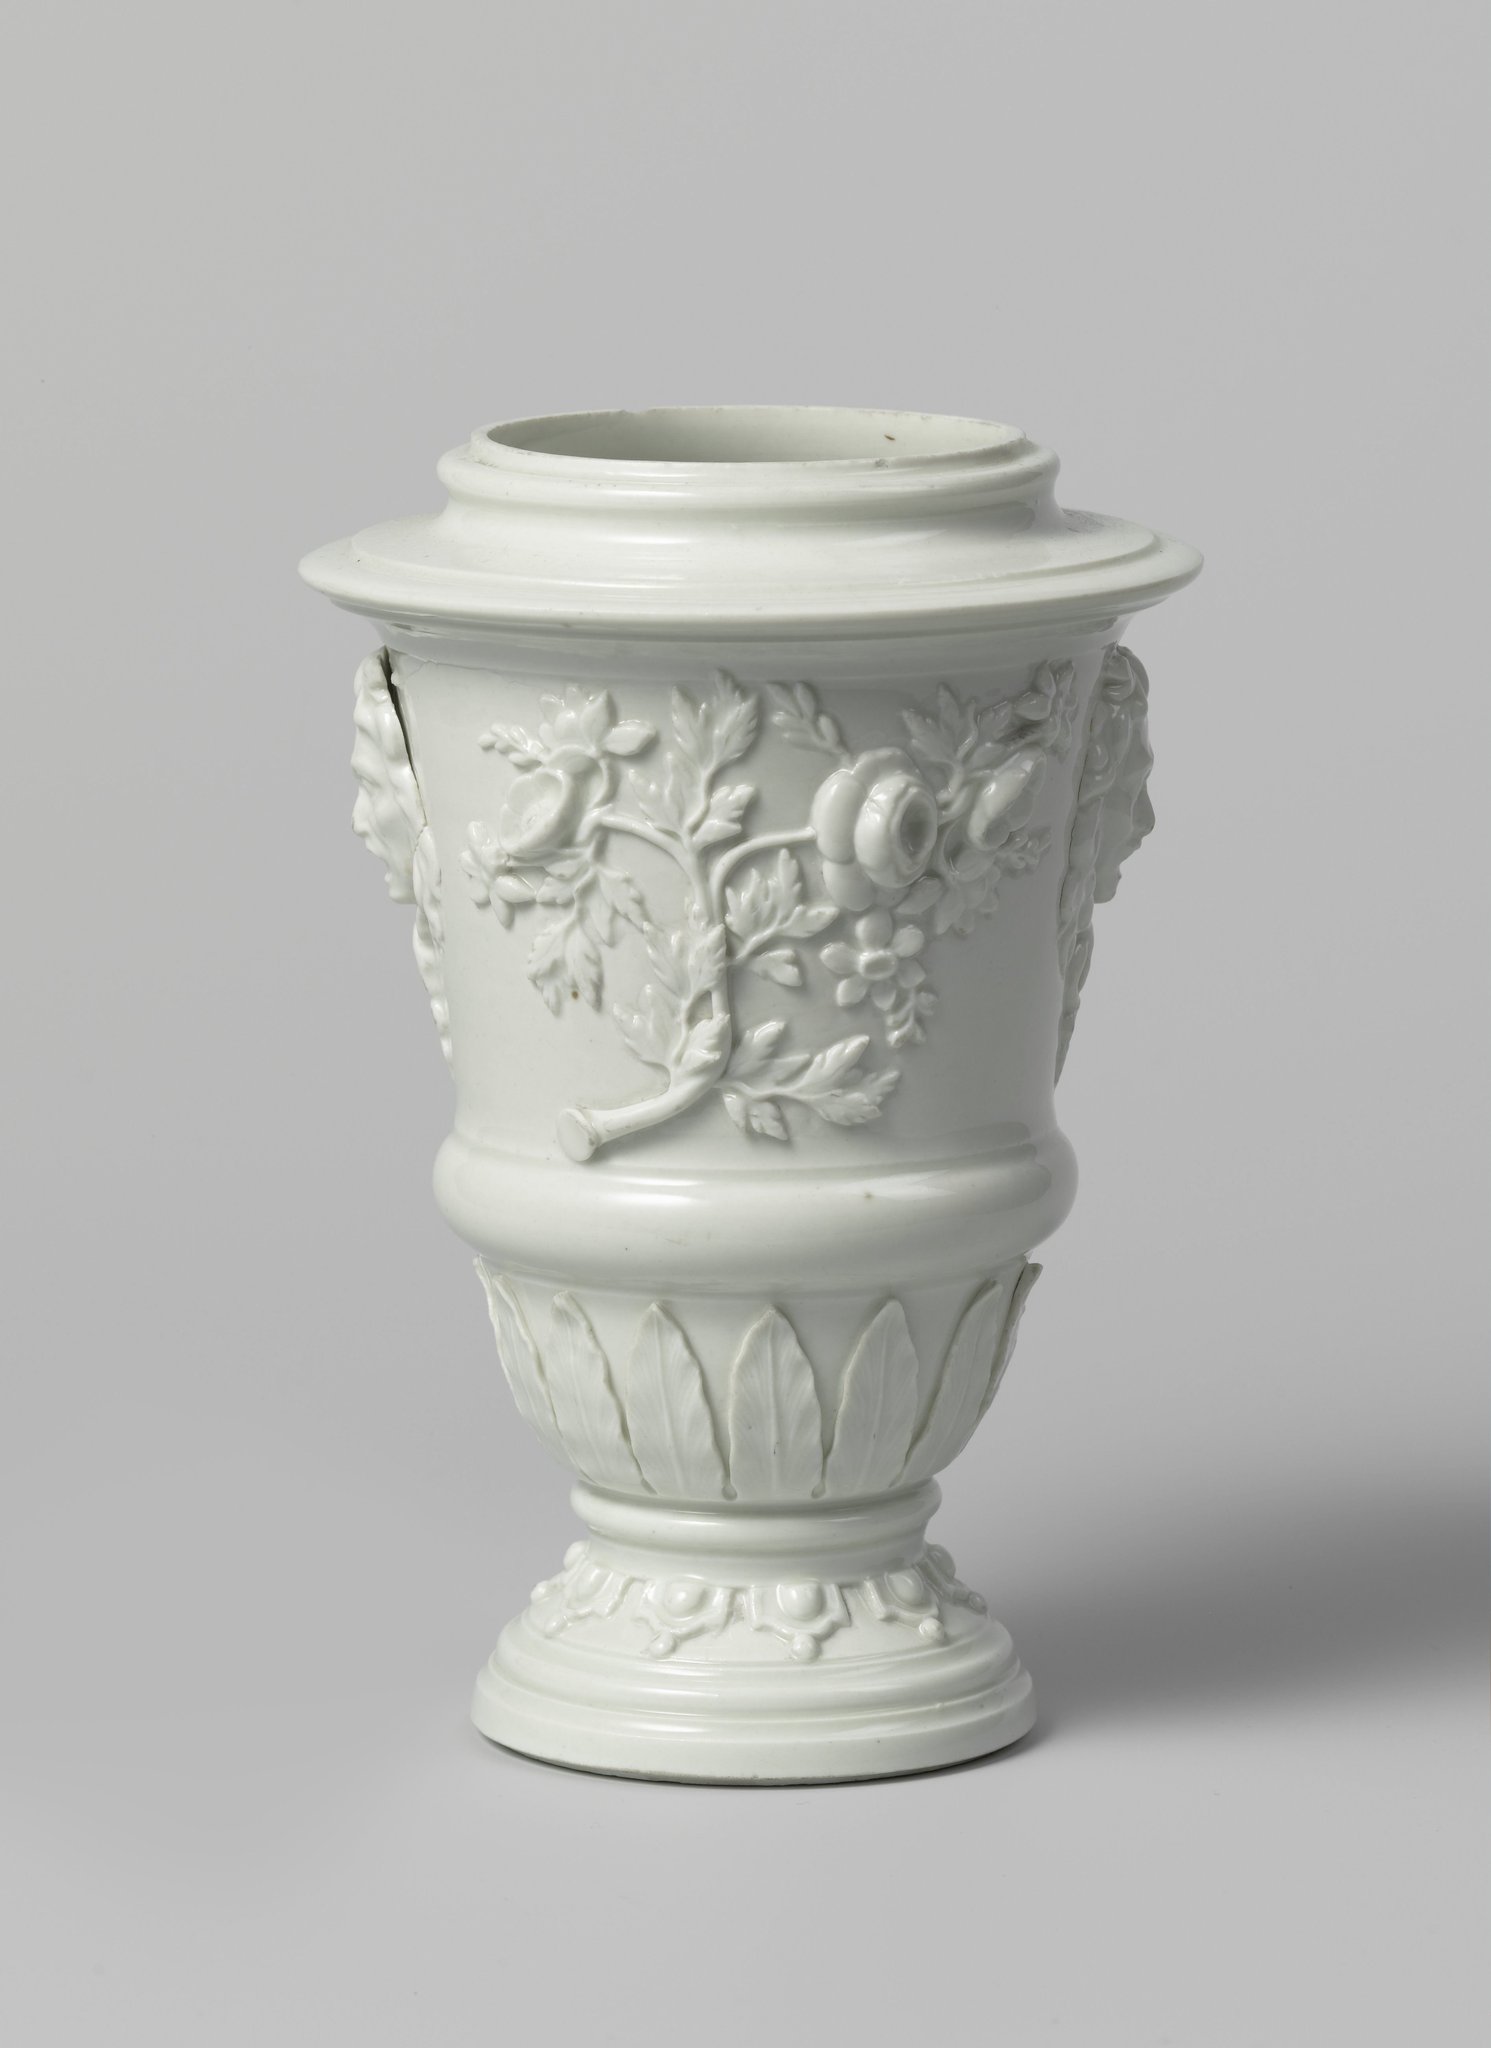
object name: vase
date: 1715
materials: porcelain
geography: meissen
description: Meissener Porzellan Manufaktur Meissen, c. 1715 hard-paste porcelain